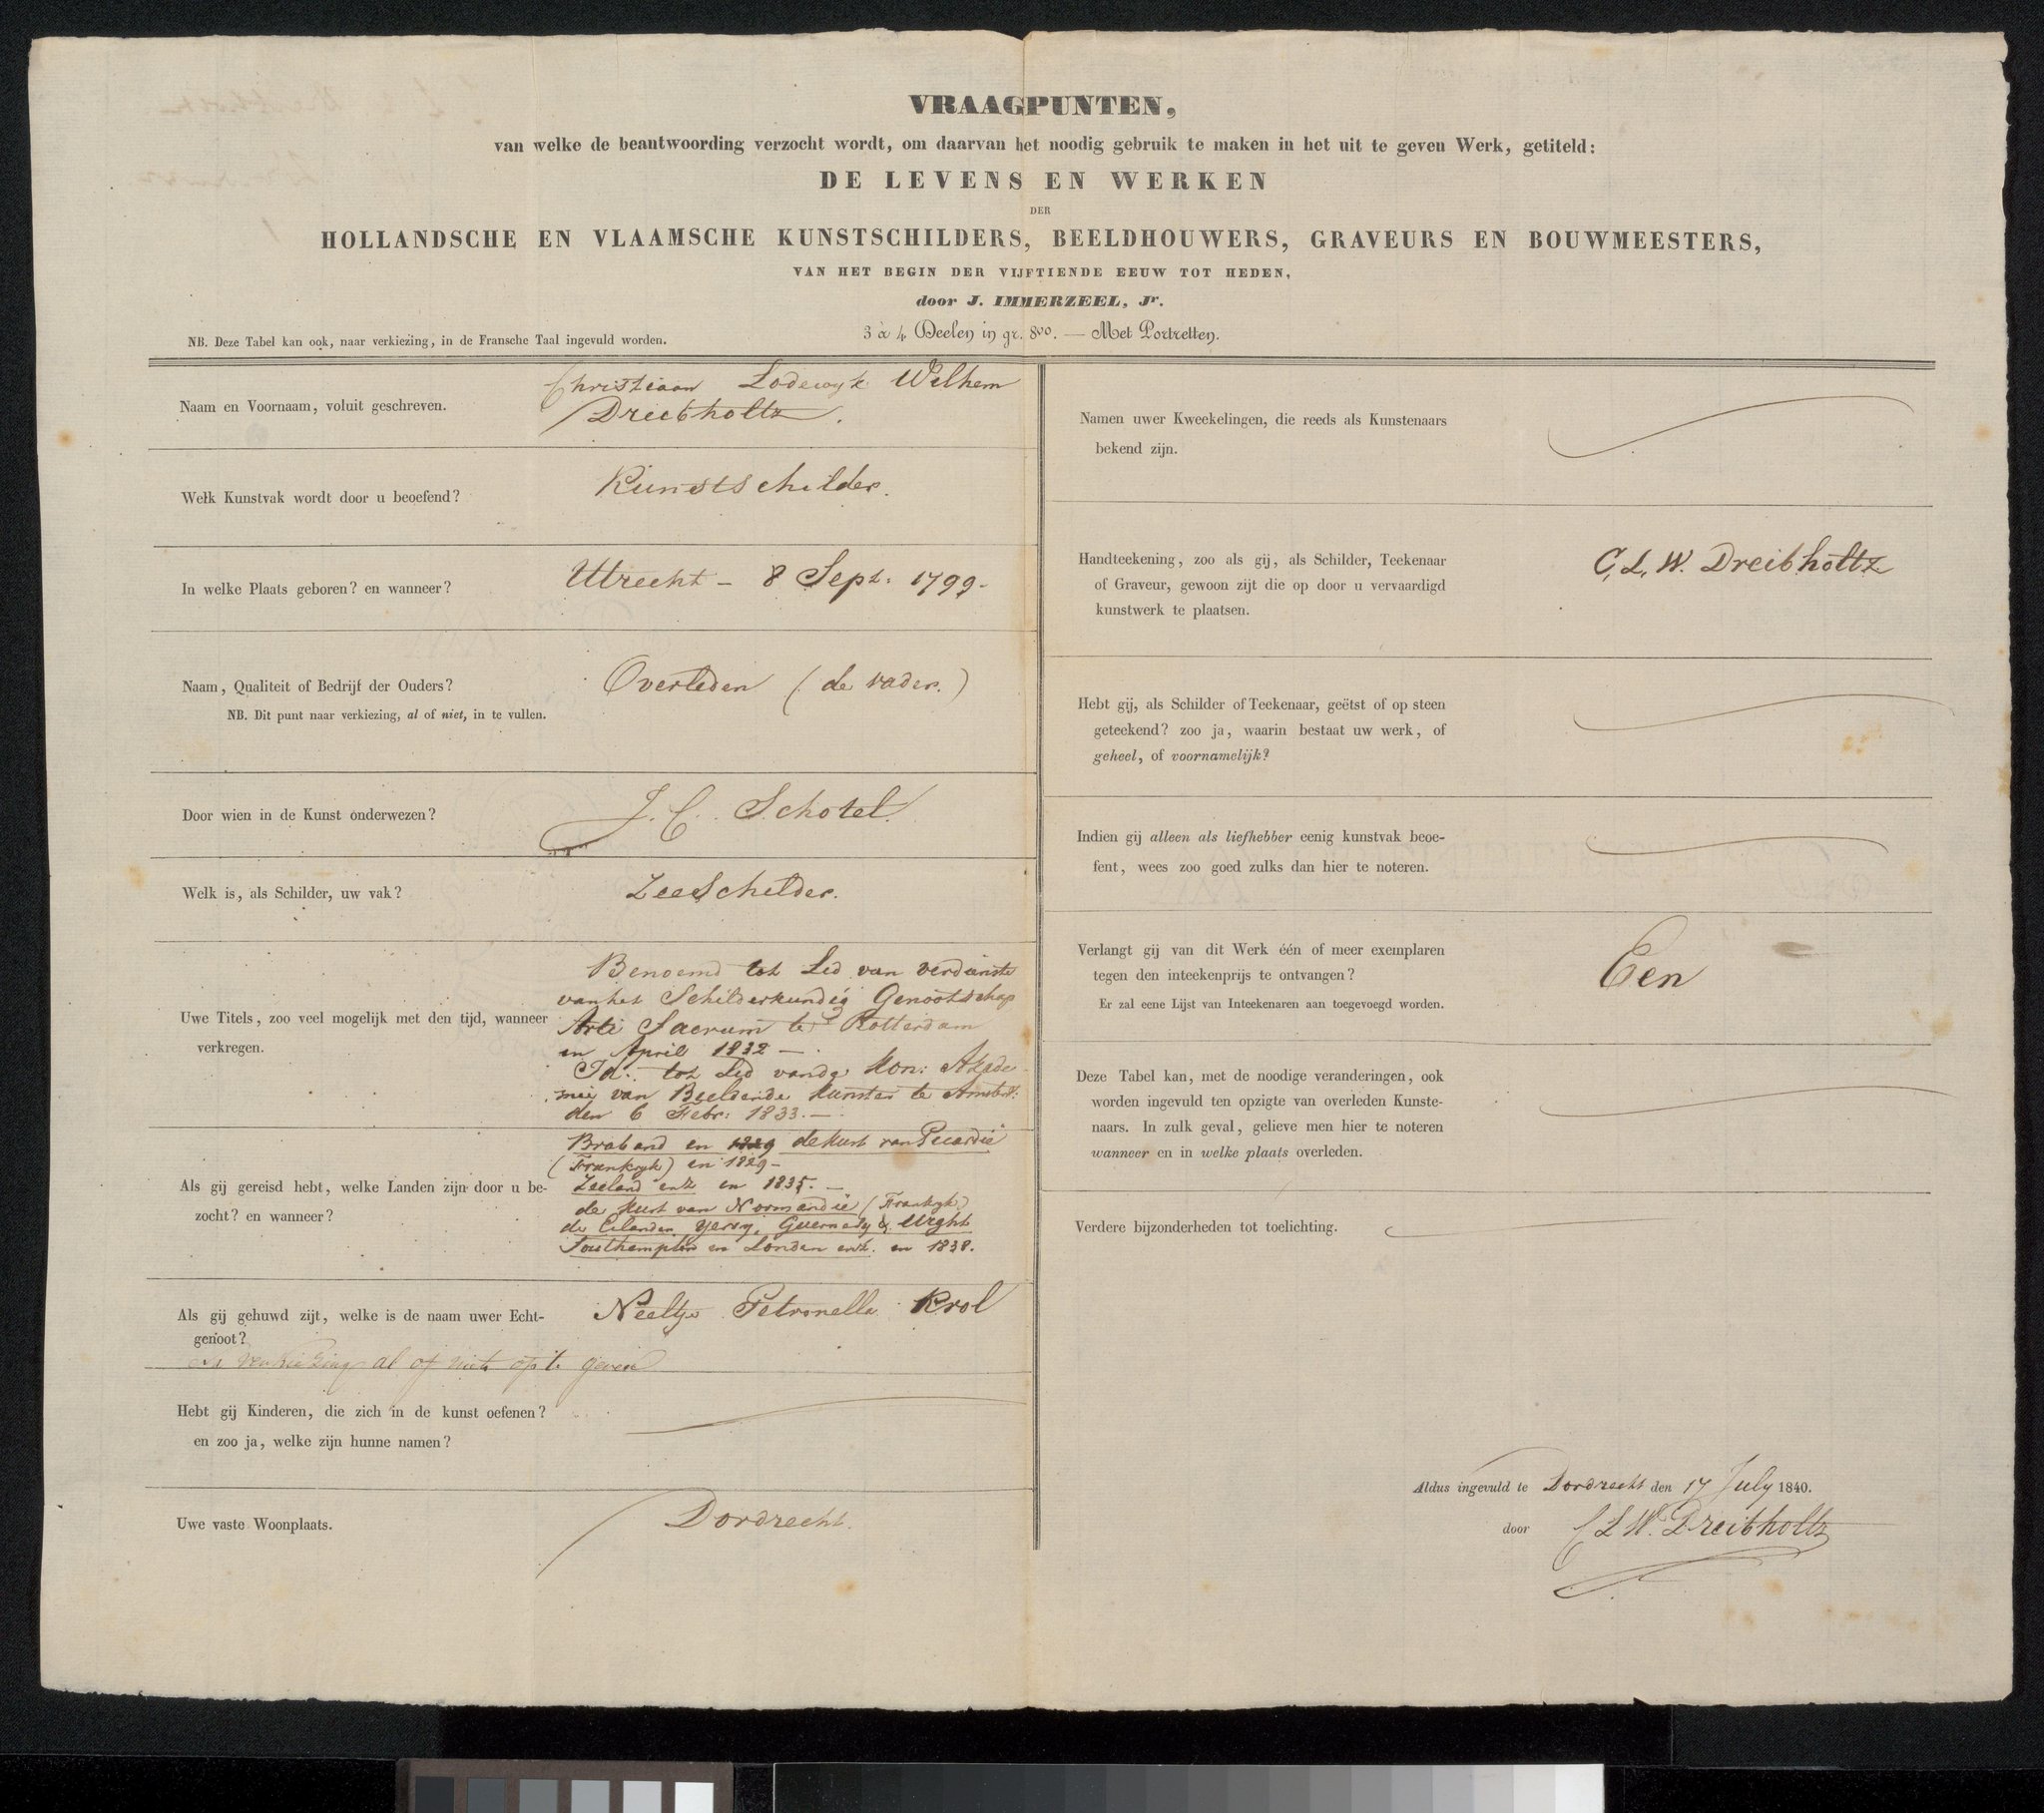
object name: questionnaire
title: Enquêteformulier ingevuld door Christiaan Lodewijk Willem Dreibholtz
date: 1840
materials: ink, paper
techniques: pen, printing, writing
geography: dordrecht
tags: utrecht, christiaan lodewijk willem dreibholtz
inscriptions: inscription: ‘Vraagpunten,/ van welke de beantwoording verzocht wordt, om daarvan het noodig gebruik te maken in het uit te geven Werk, getiteld: De levens en werken/ der Hollandsche en Vlaamsche kunstschilders, beeldhouwers,/ graveurs en bouwmeesters, van het begin der vijftiende eeuw tot heden/ door J. Immerzeel, Jr.’, watermark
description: Opgenomen in: Immerzeel, J. Jr., De levens en werken der Hollandsche en Vlaamsche kunstschilders, beeldhouwers, graveurs en bouwmeesters, van het begin der vijftiende eeuw tot heden, Amsterdam: J.C. van Kesteren, 1842-1843.